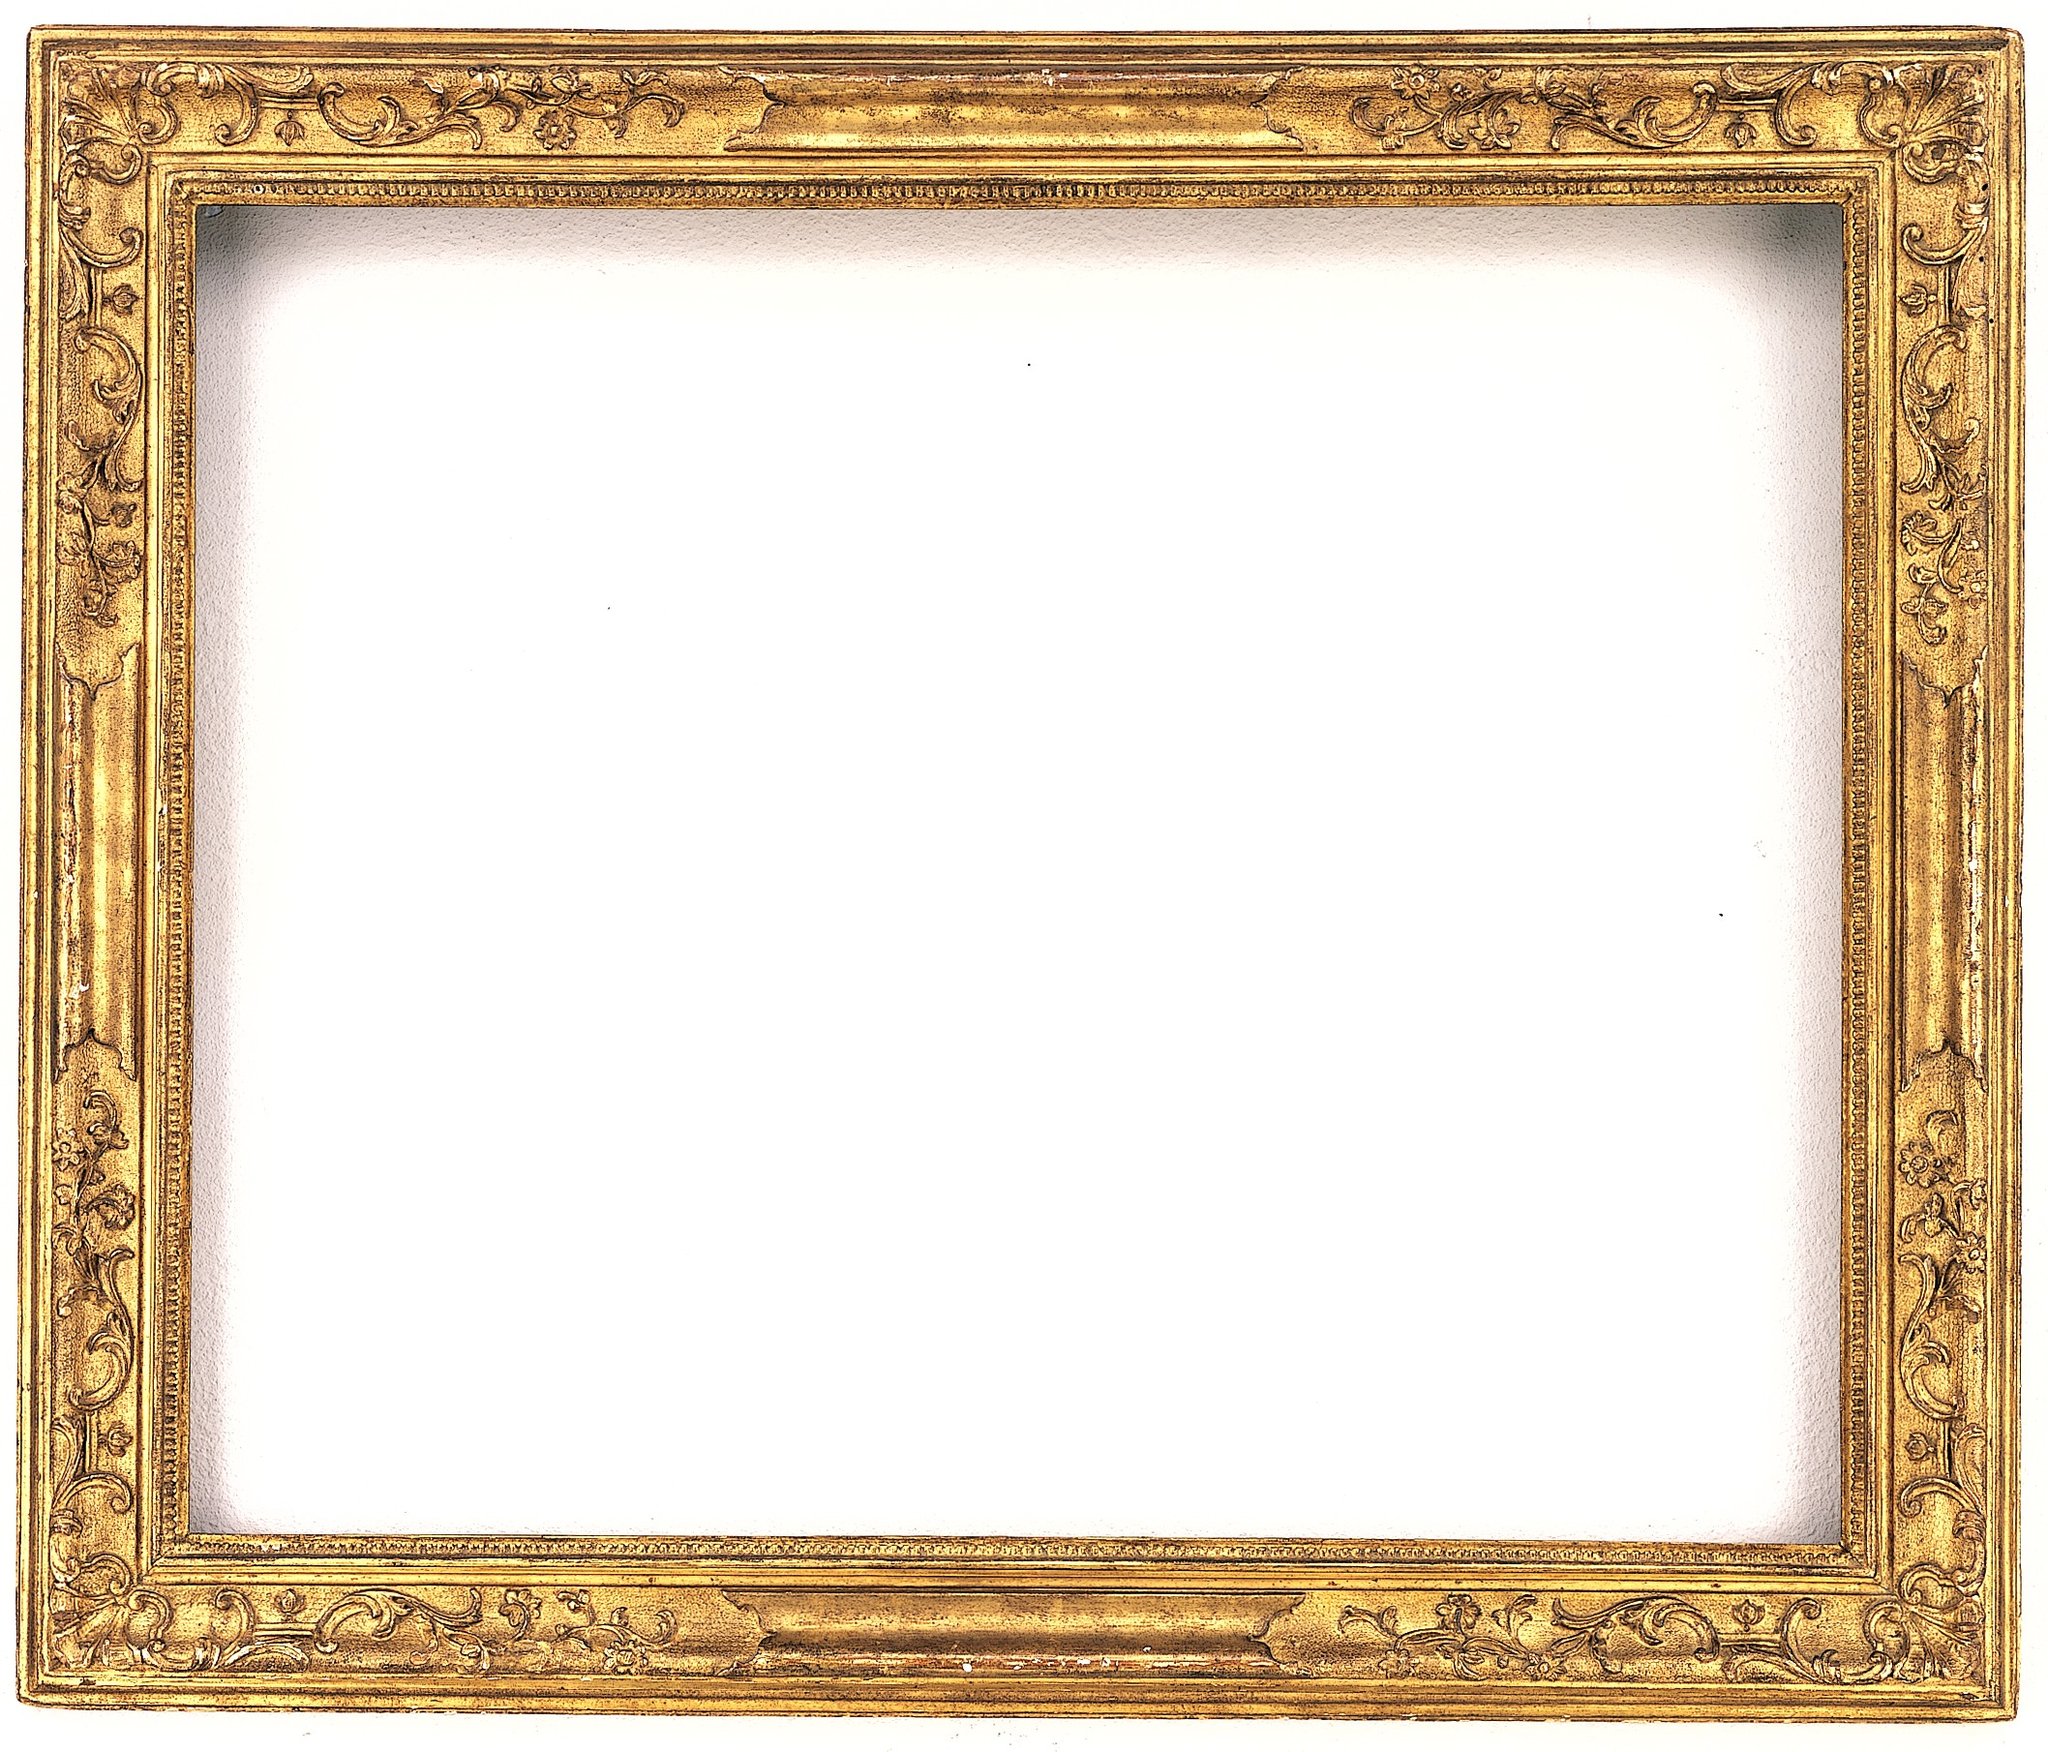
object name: frame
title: Canaletto frame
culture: italian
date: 1720-1740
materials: wood